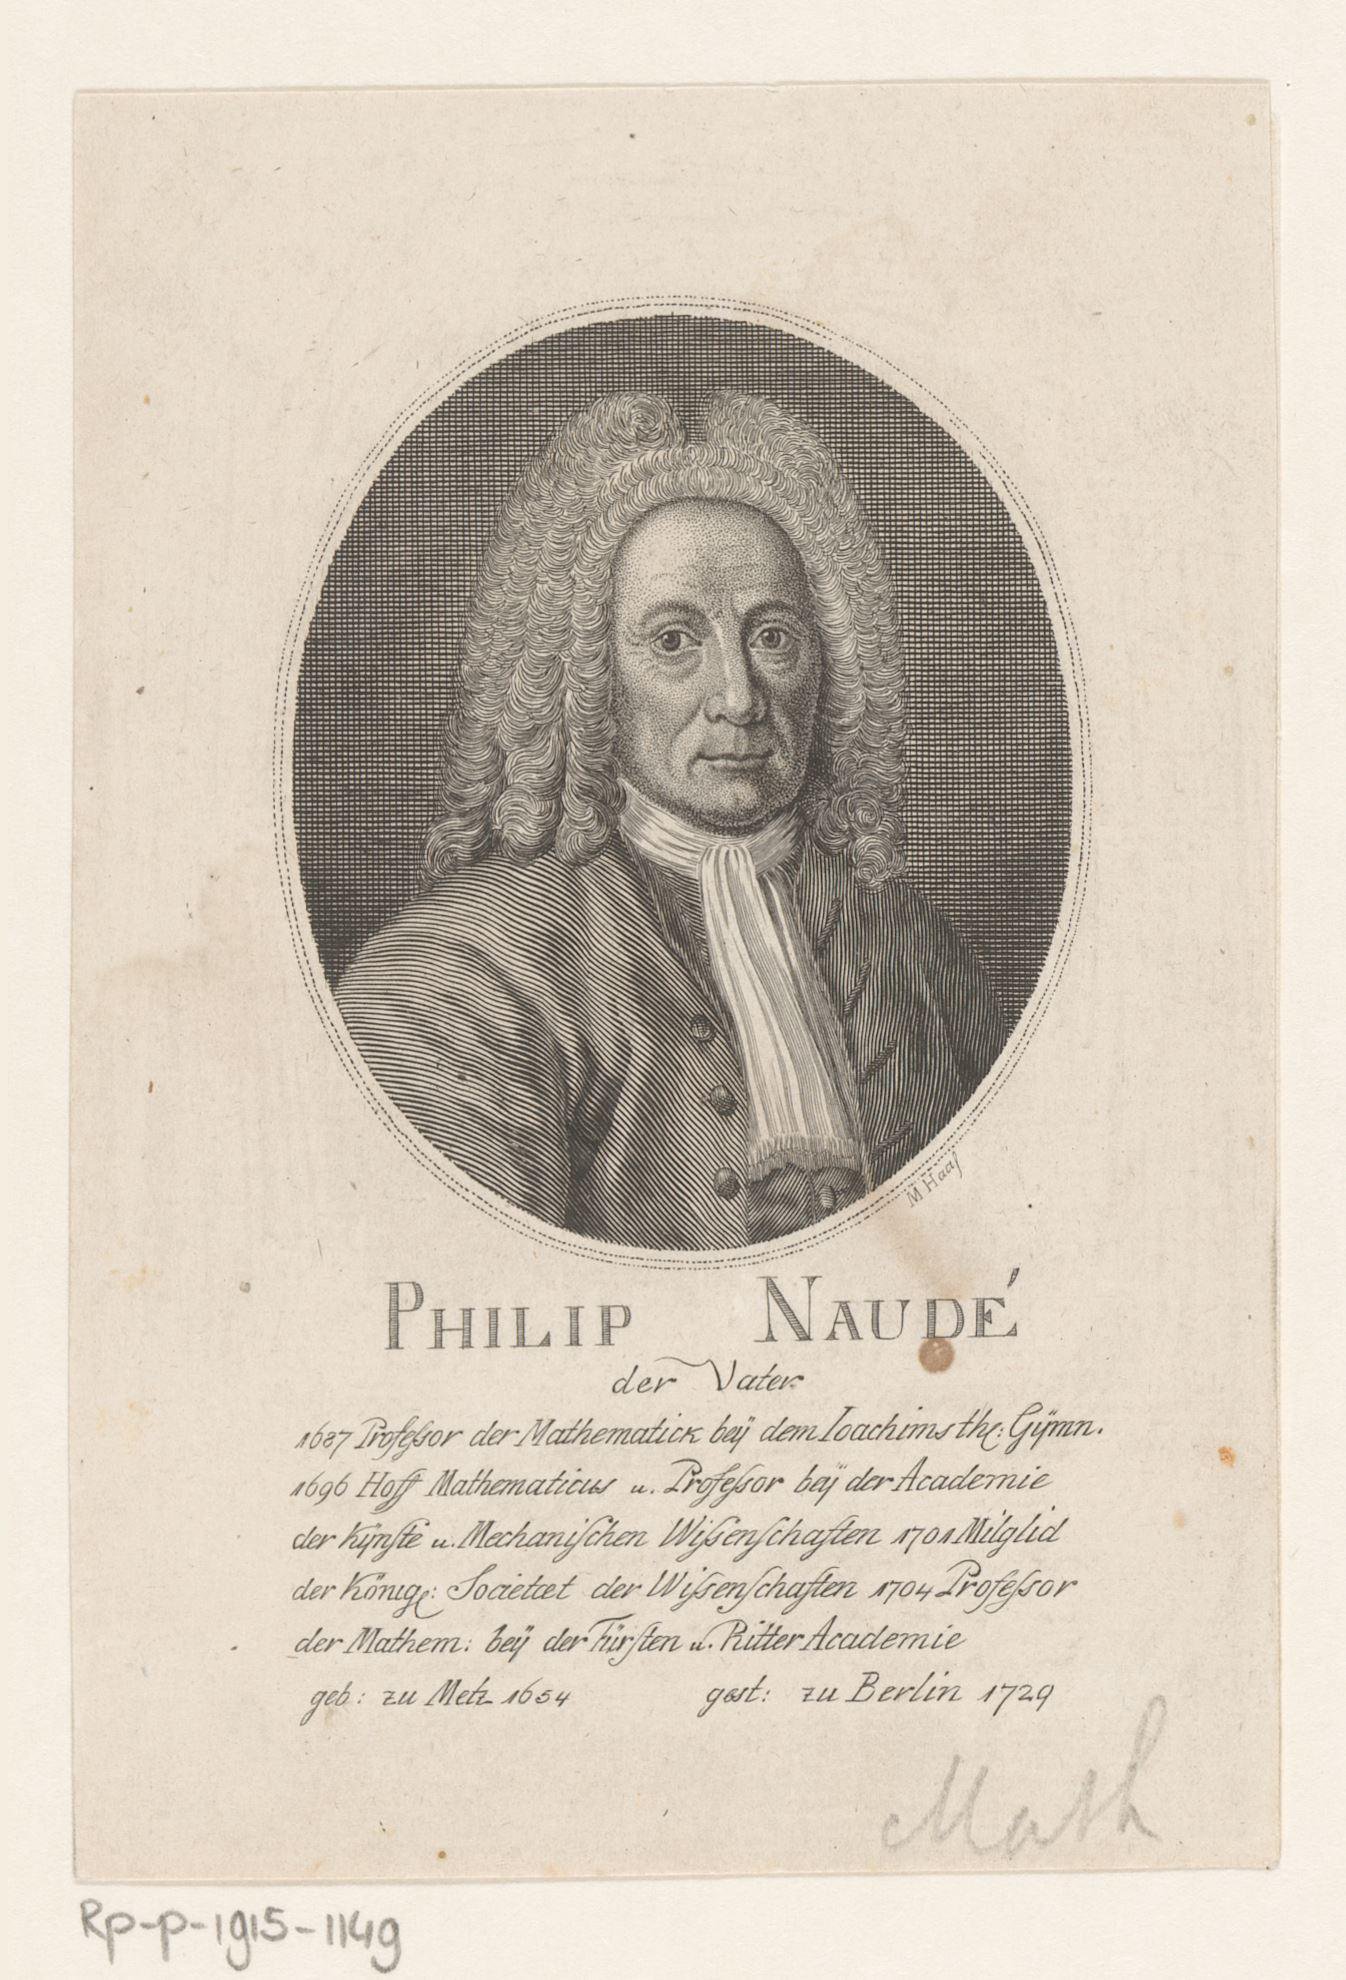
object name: print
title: Portret van Philipp Naudé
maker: meno haas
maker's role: print maker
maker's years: 1752-1833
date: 1762-1833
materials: paper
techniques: engraving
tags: historical persons, mathematics